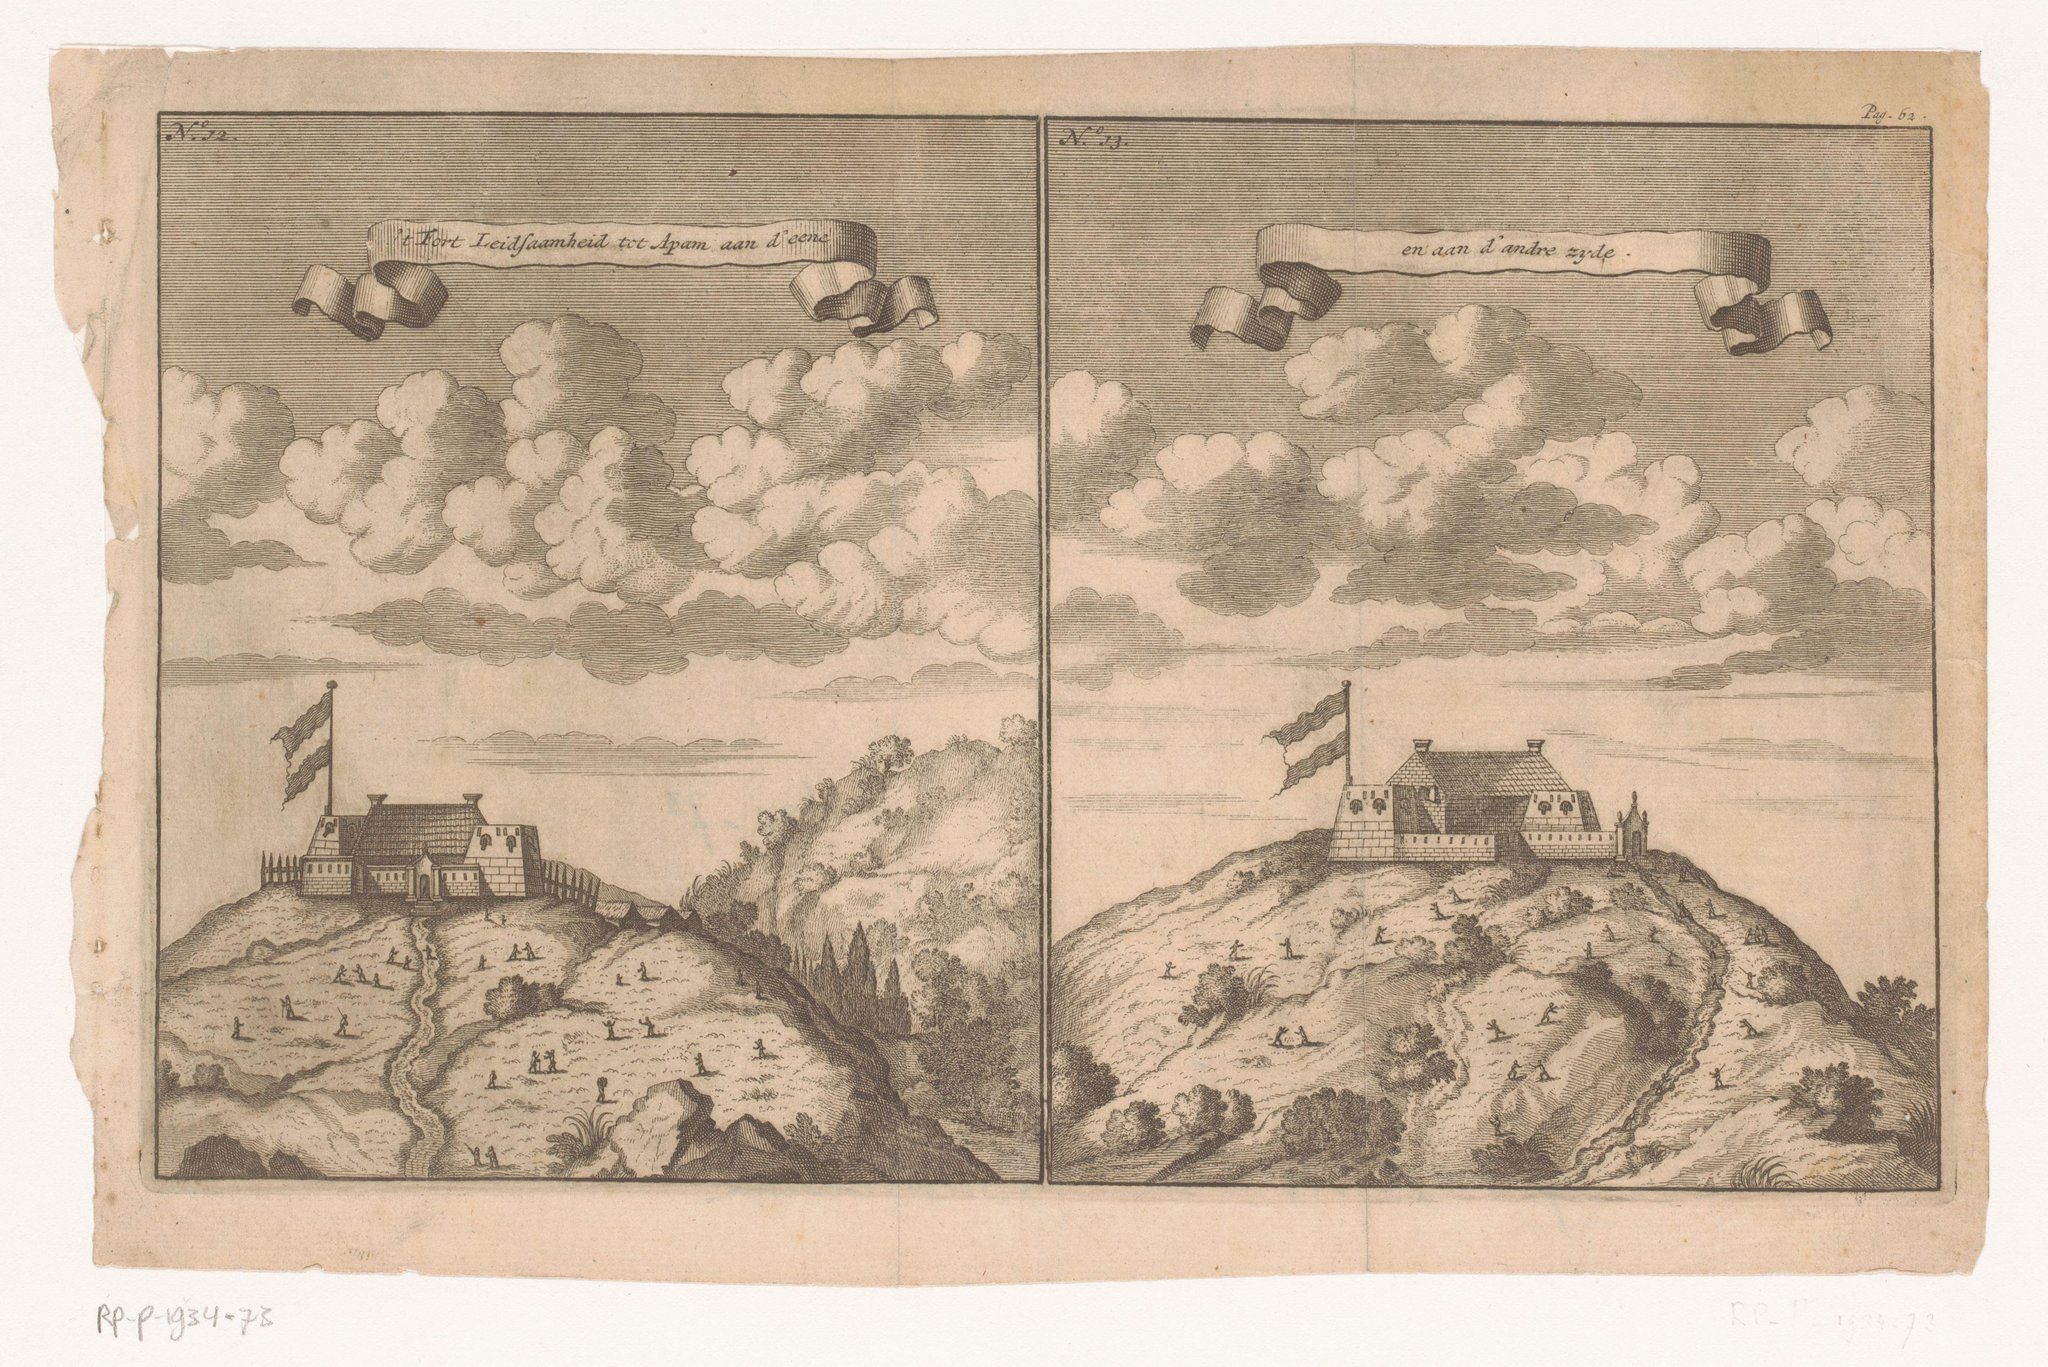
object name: print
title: Fort Lijdzaamheid te Apam in Ghana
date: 1709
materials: paper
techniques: etching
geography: amsterdam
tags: fortress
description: Prent uit: Bosman, Willem. Nauwkeurige beschryving van de Guinese goud- tand- en slavekust. Amsterdam: Isaac Stokmans, 1709, dl. 1, p. 62.